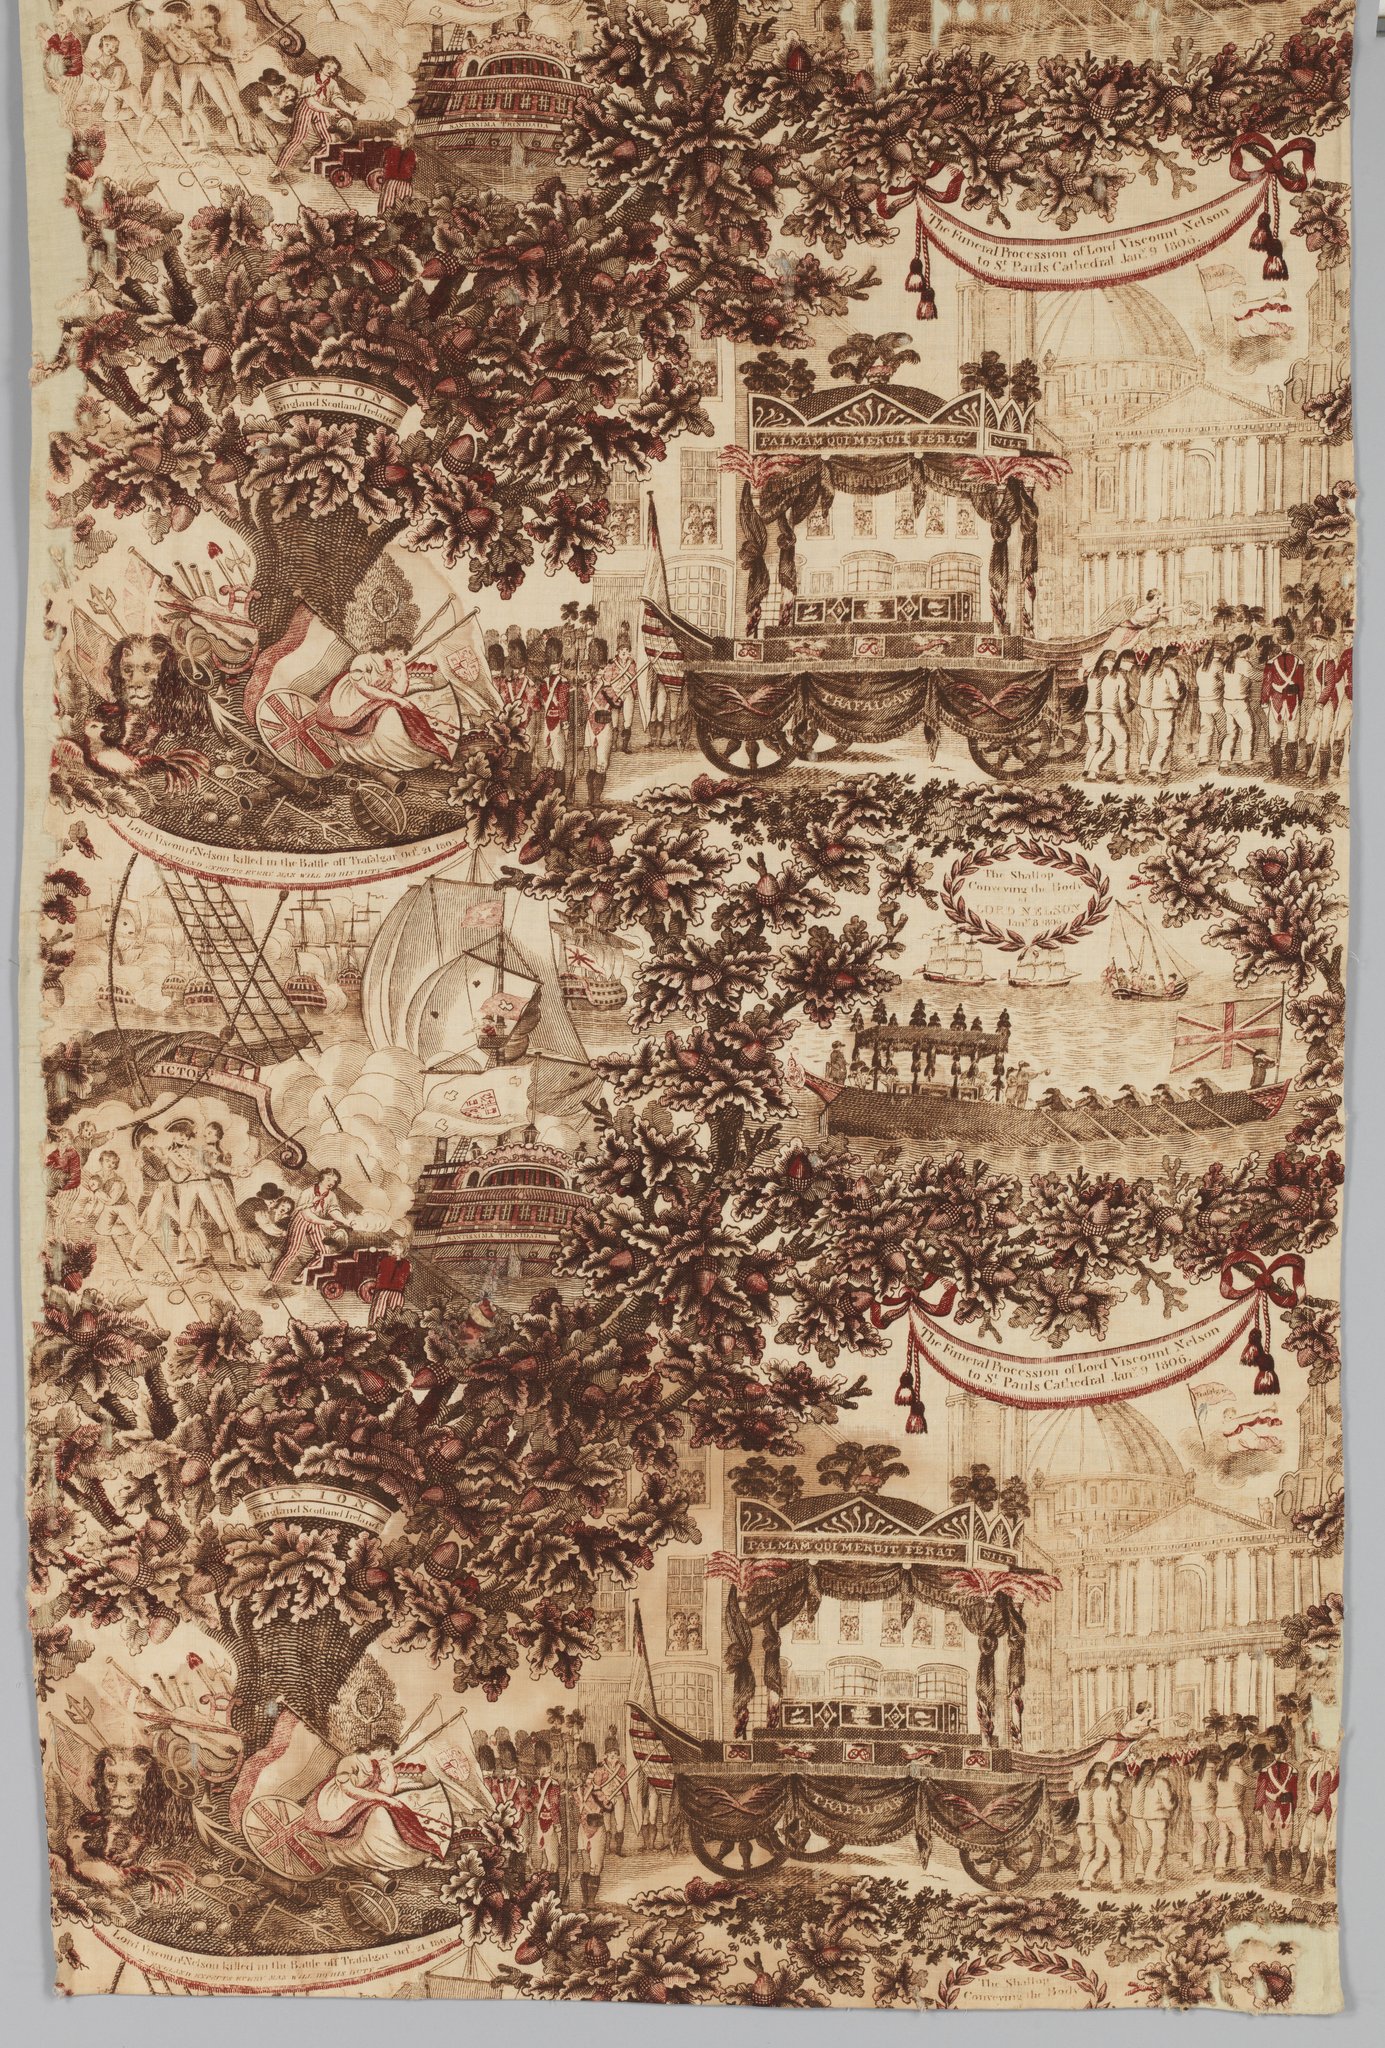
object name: piece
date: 1806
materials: cotton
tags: human figures,soldiers,trees